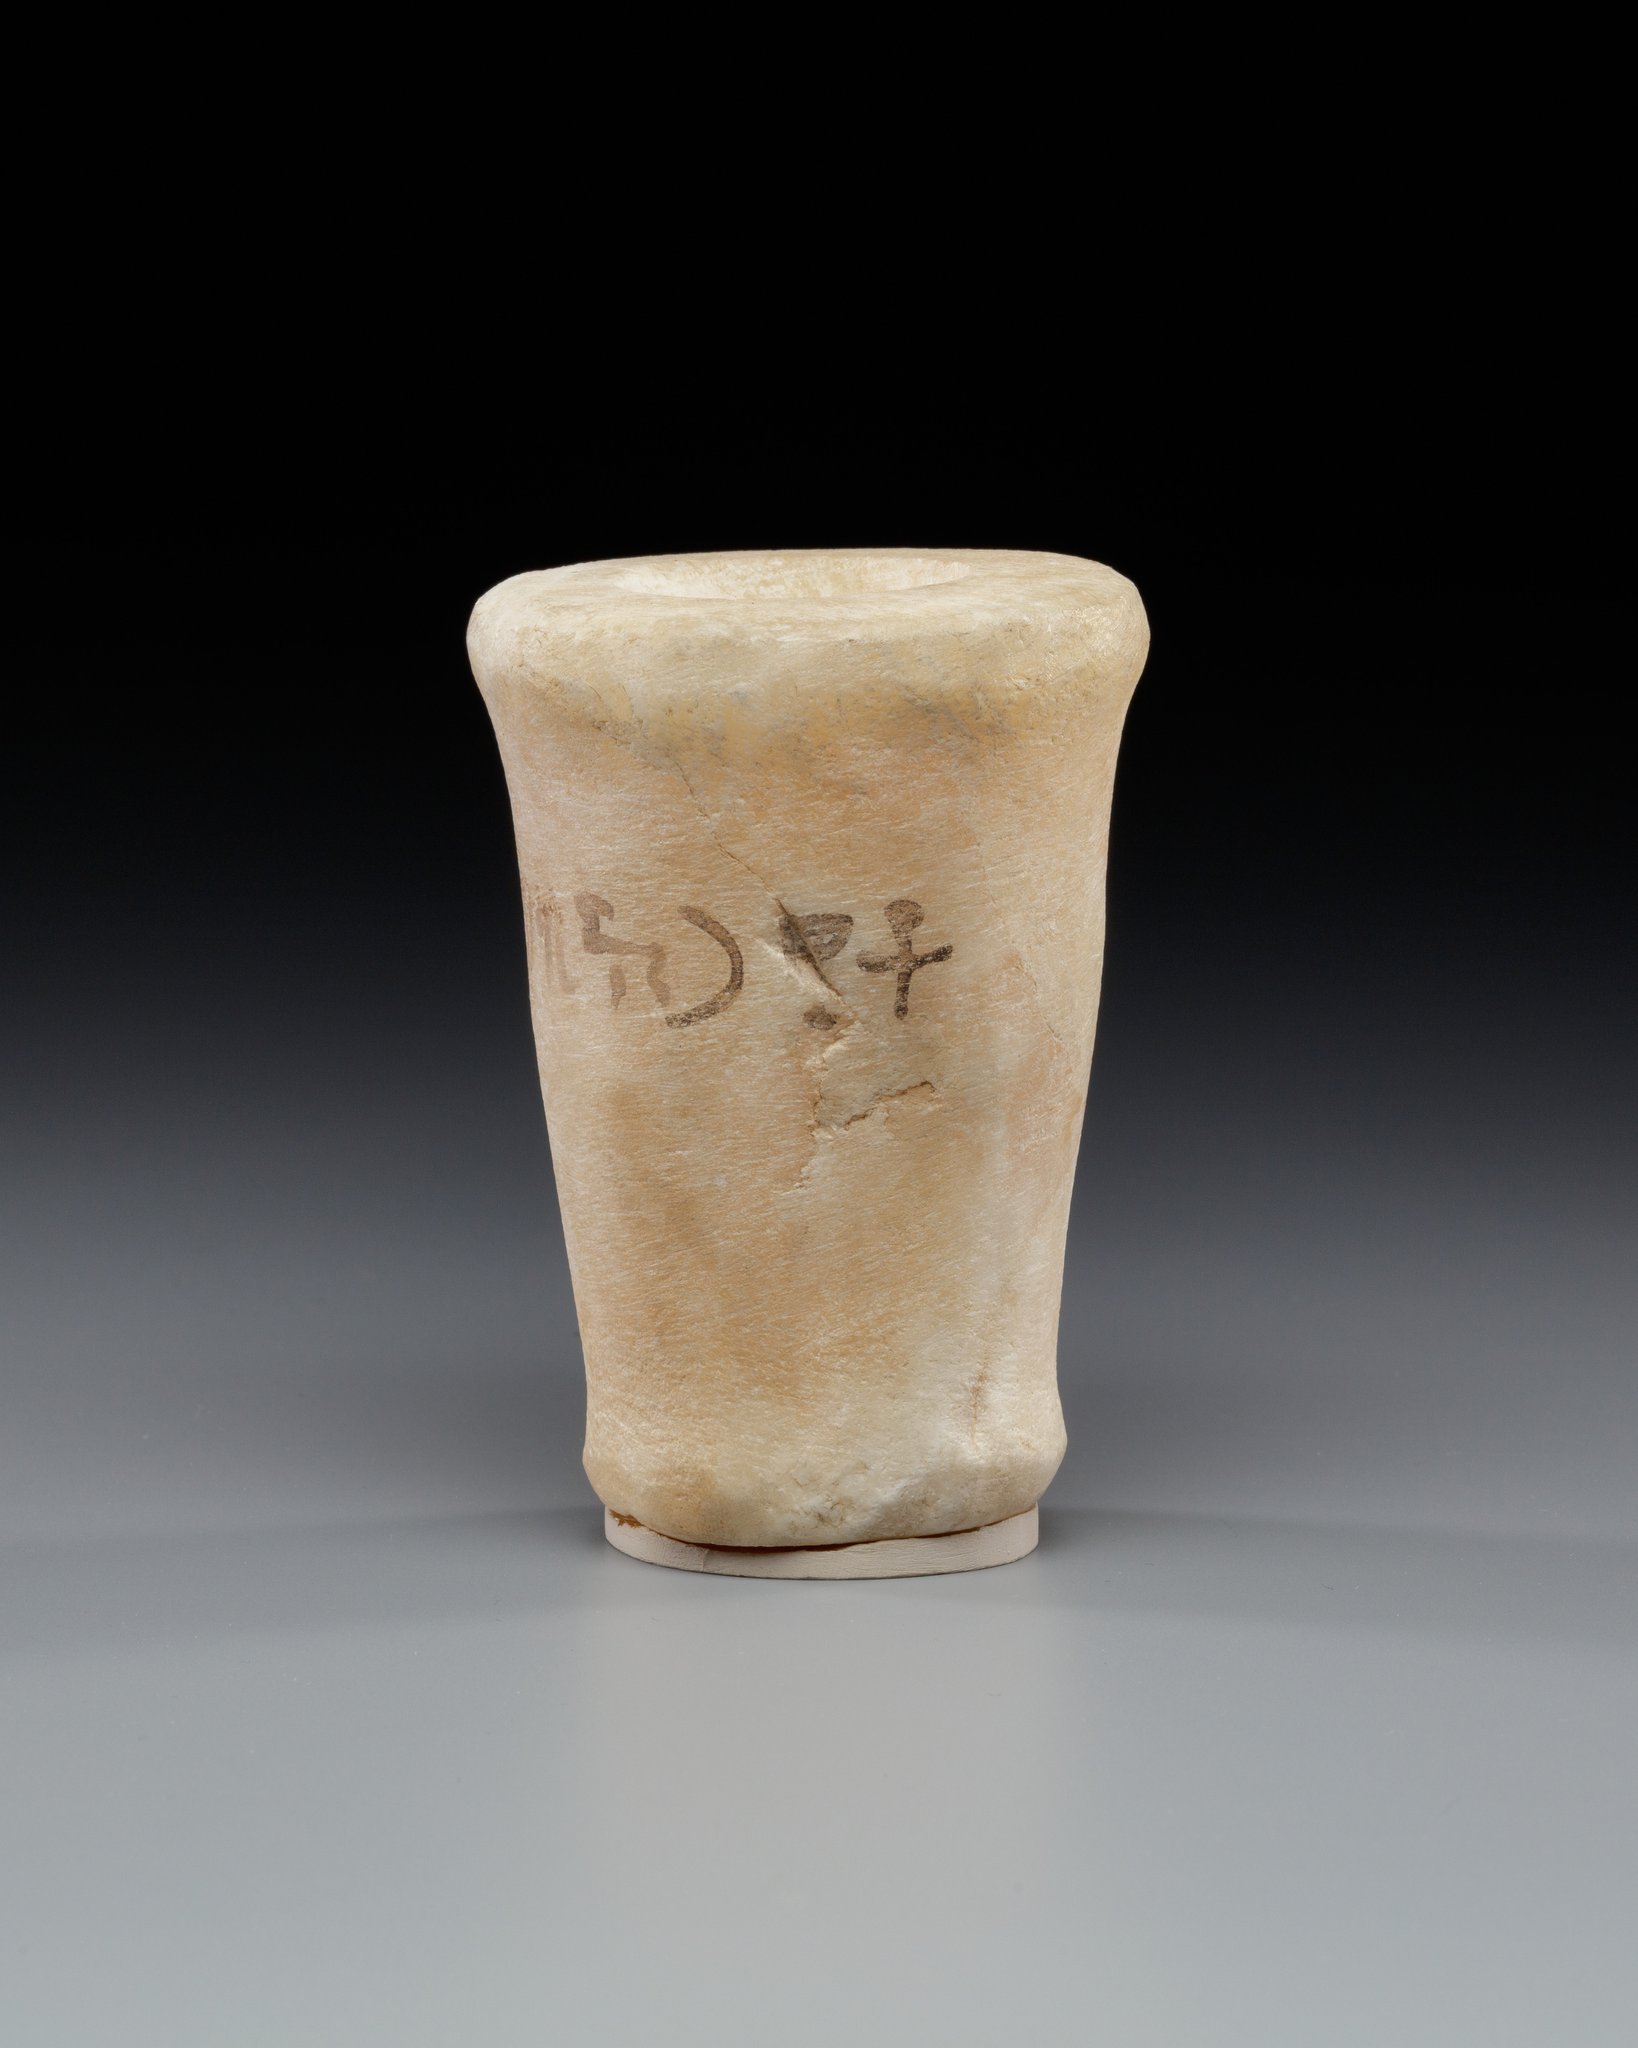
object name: model, ointment jar, foundation deposit, hatshepsut merytre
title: Model Ointment Jar from a Foundation Deposit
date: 1479-1425 BCE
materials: paint, stone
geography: egypt